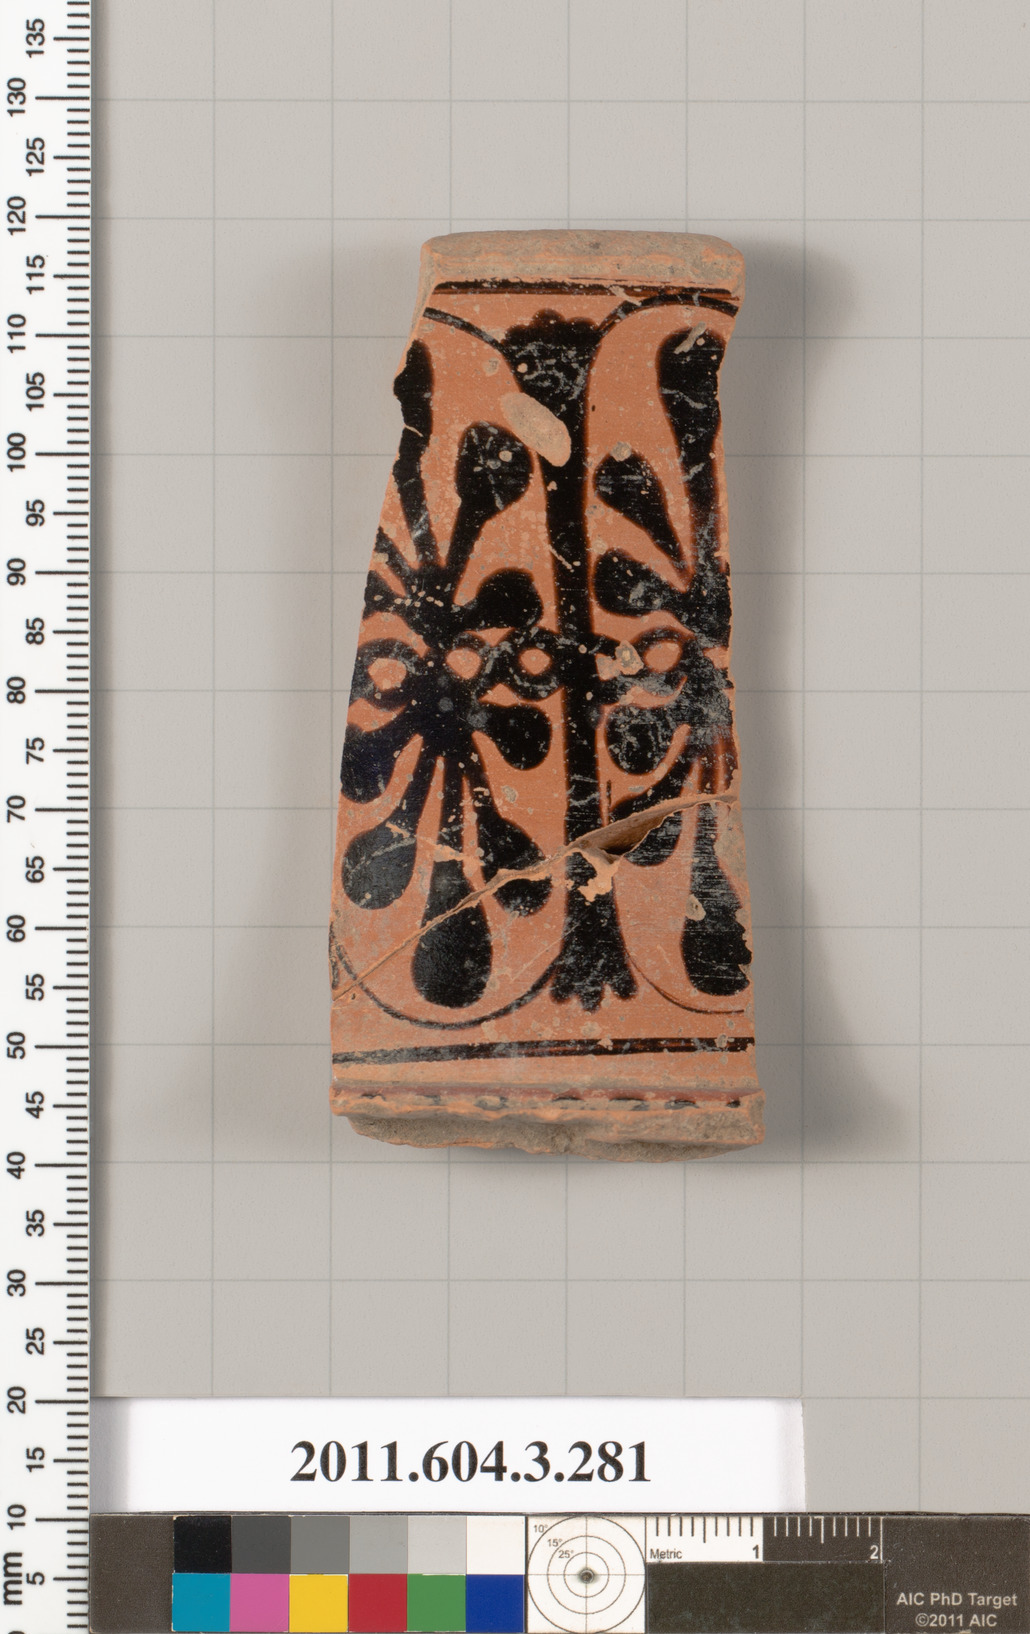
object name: neck amphora fragment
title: Terracotta fragment of a neck-amphora (jar)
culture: greek, attic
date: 520-510 BCE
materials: terracotta